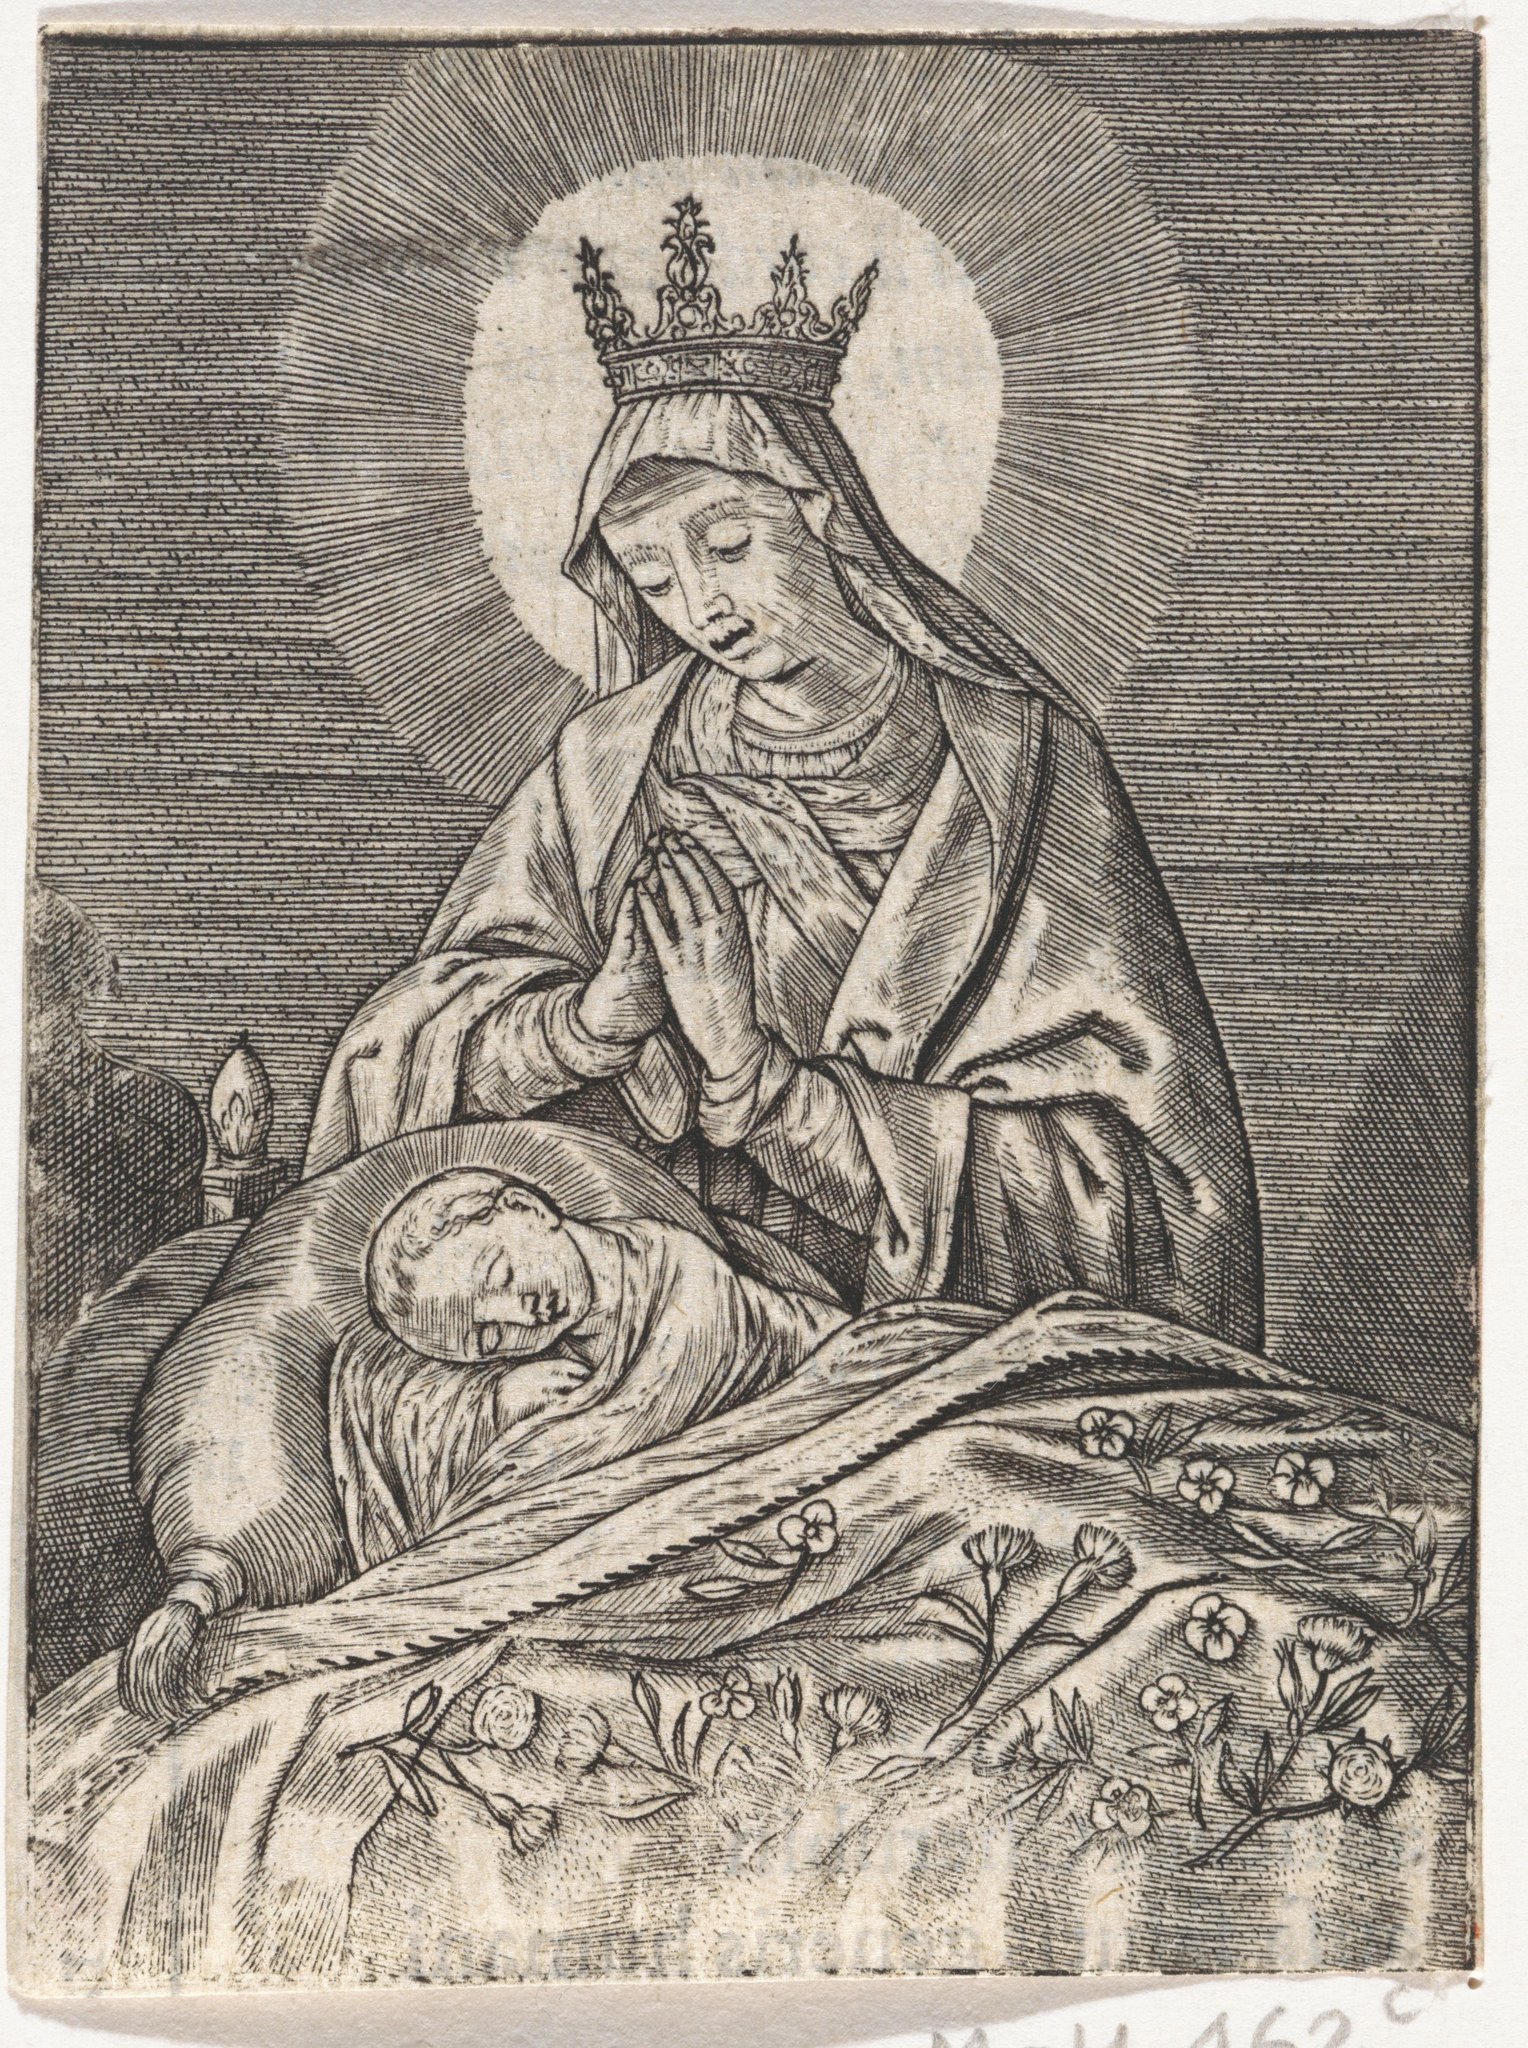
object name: book illustration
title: Maria en het slapende Christuskind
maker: Anonymous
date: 1563-1669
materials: paper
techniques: engraving, letterpress printing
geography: antwerp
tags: madonna: i.e. mary with the christ-child, sleeping; unconsciousness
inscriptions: collector's mark: Lugt 2228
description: De gekroonde Maria kijkt naar het slapende Christuskind, haar handen gevouwen voor haar borst. Op de deken van het Kind liggen verschillende bloemen verspreid.